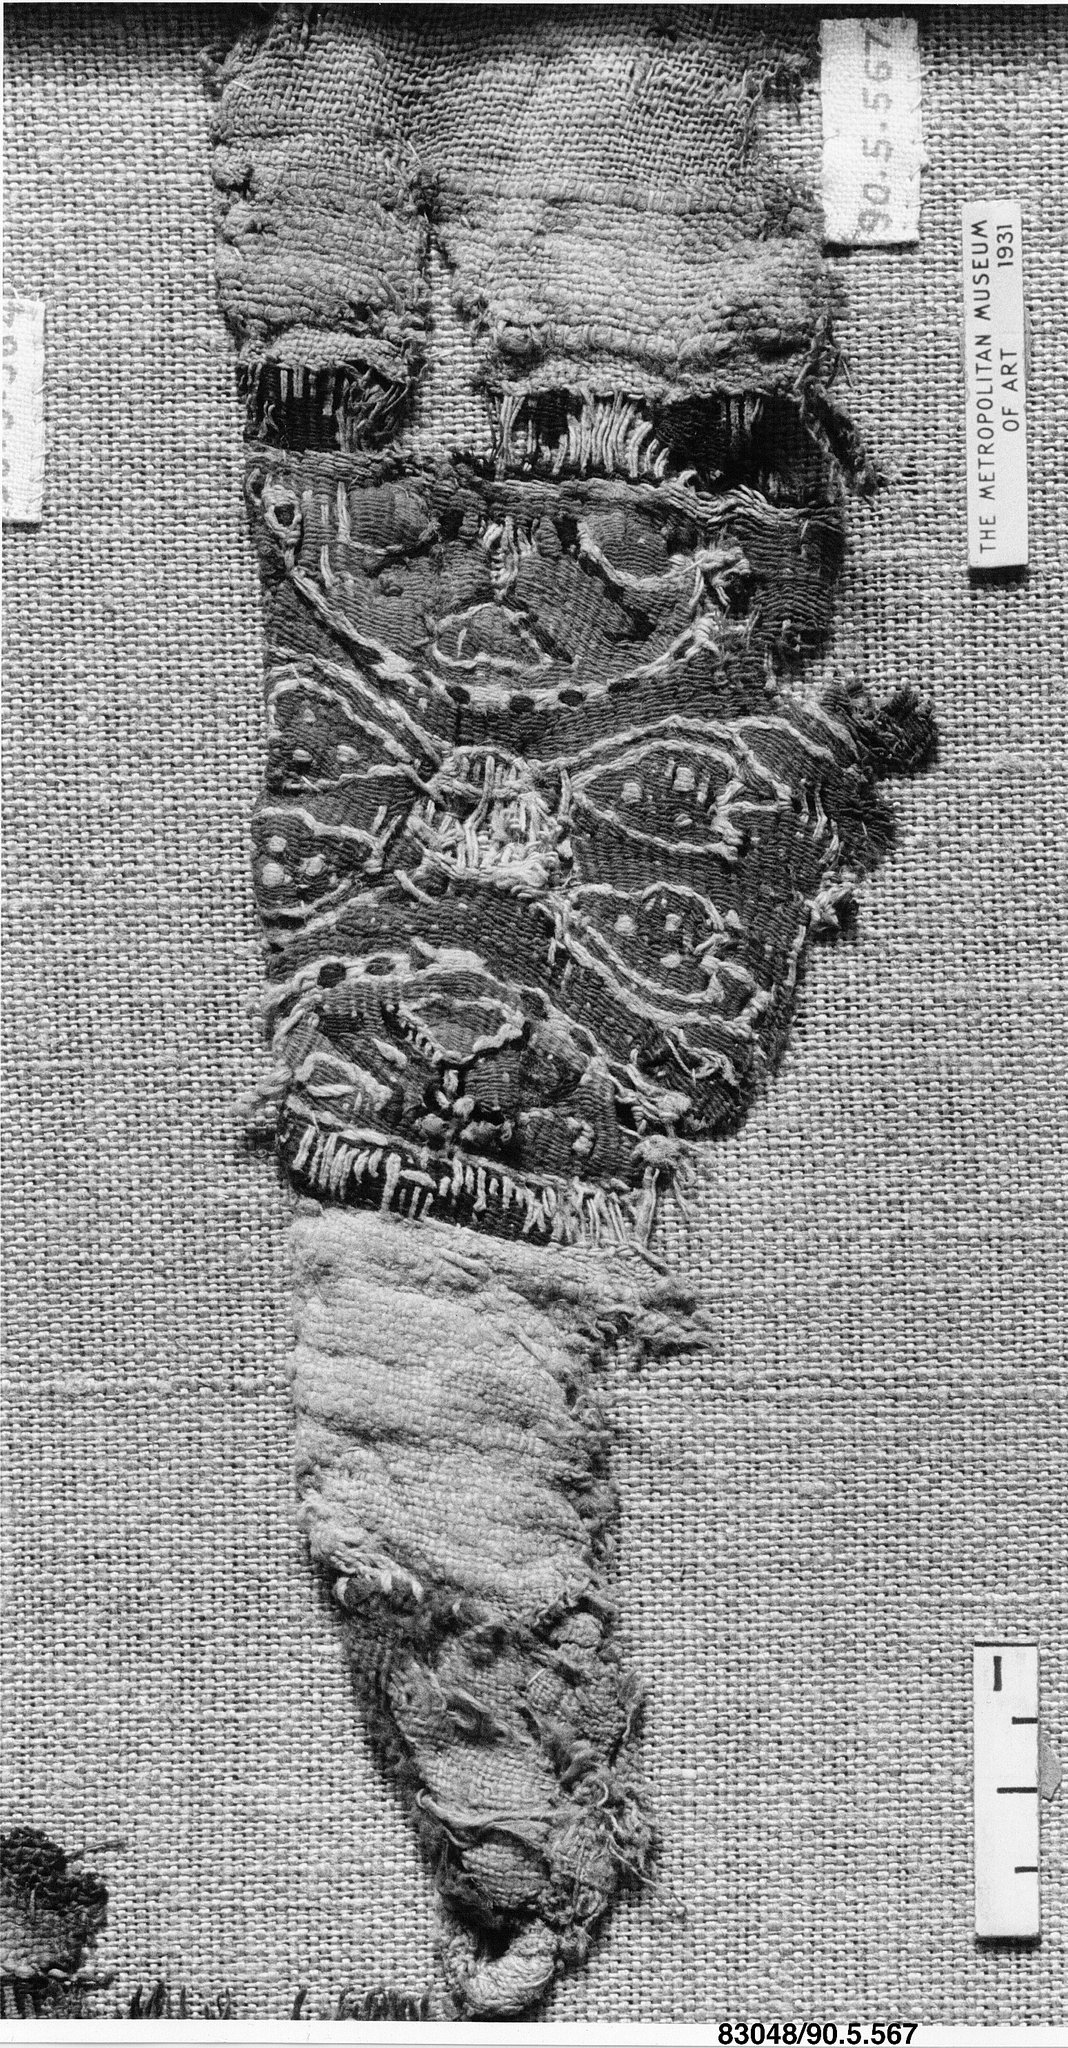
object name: textile fragment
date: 401-600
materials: linen, wool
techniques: weave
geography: egypt